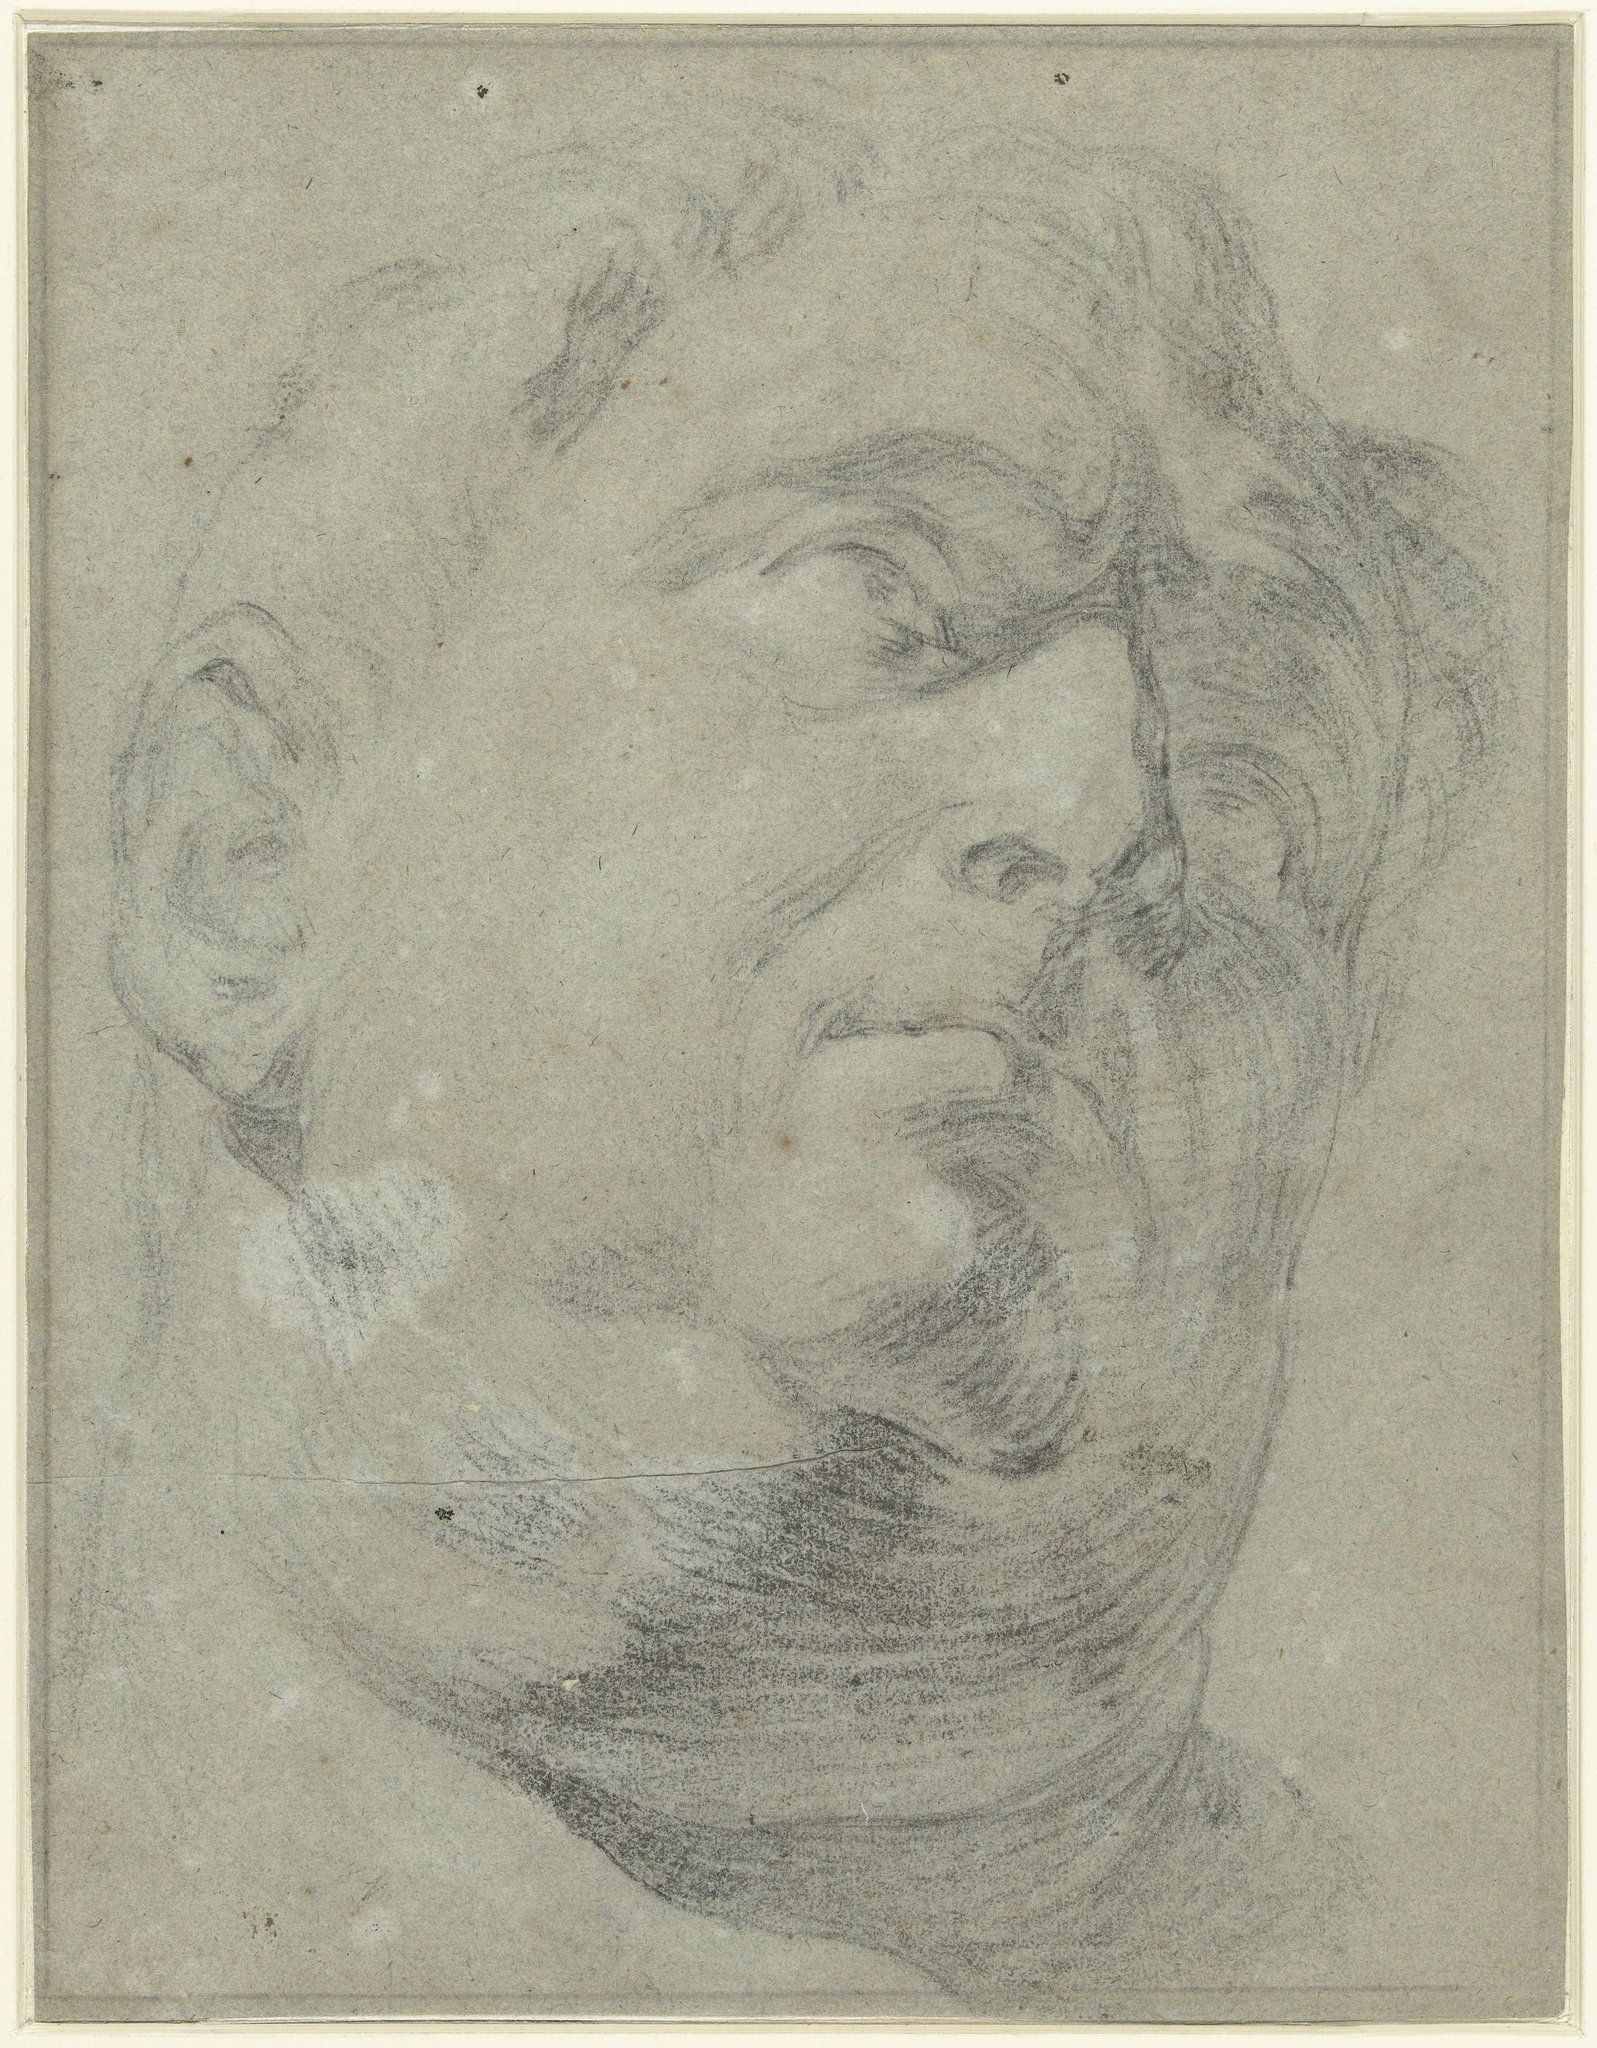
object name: drawing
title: Antiek romeins marmeren buste van Presunto Vitellio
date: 1600-1699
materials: chalk, paper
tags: rome, head (human), historical persons, emperor, piece of sculpture, reproduction of a piece of sculpture (+ roman art), male sex; man